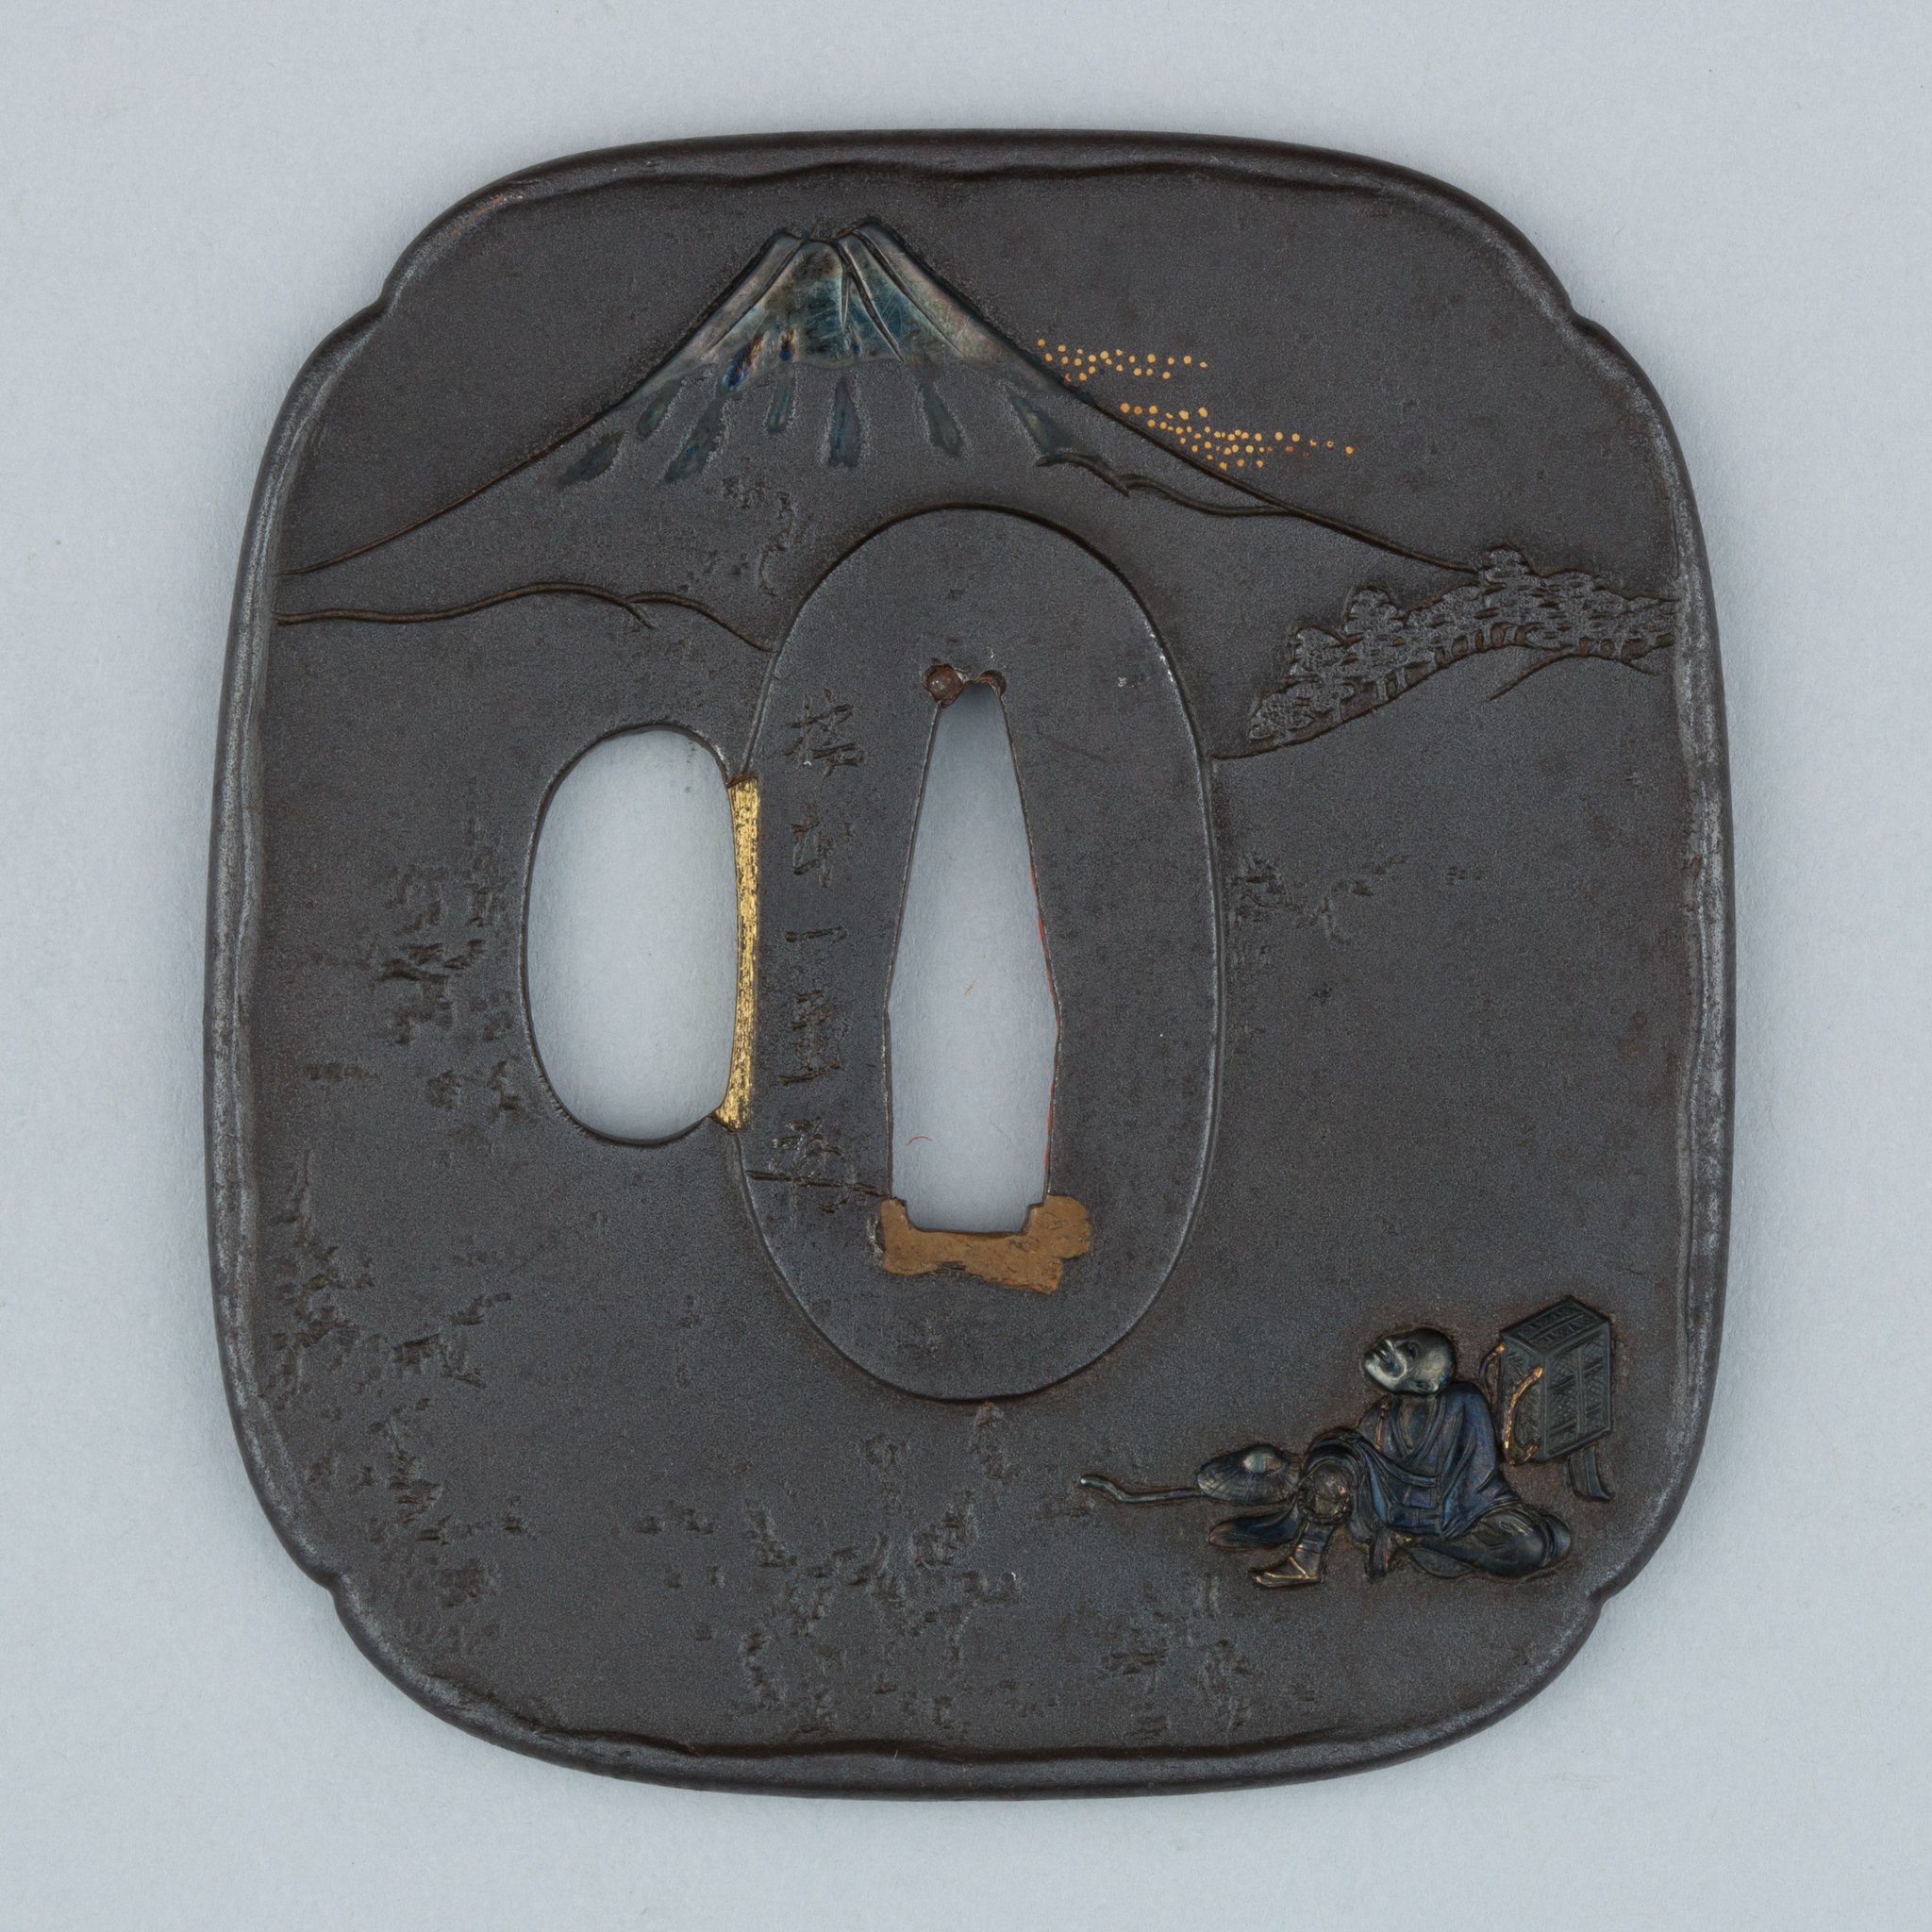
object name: sword guard tsuba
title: Sword Guard (Tsuba)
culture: japanese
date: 1801-1833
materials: copper, gold alloy, gold, iron, silver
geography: japan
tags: men,mountains